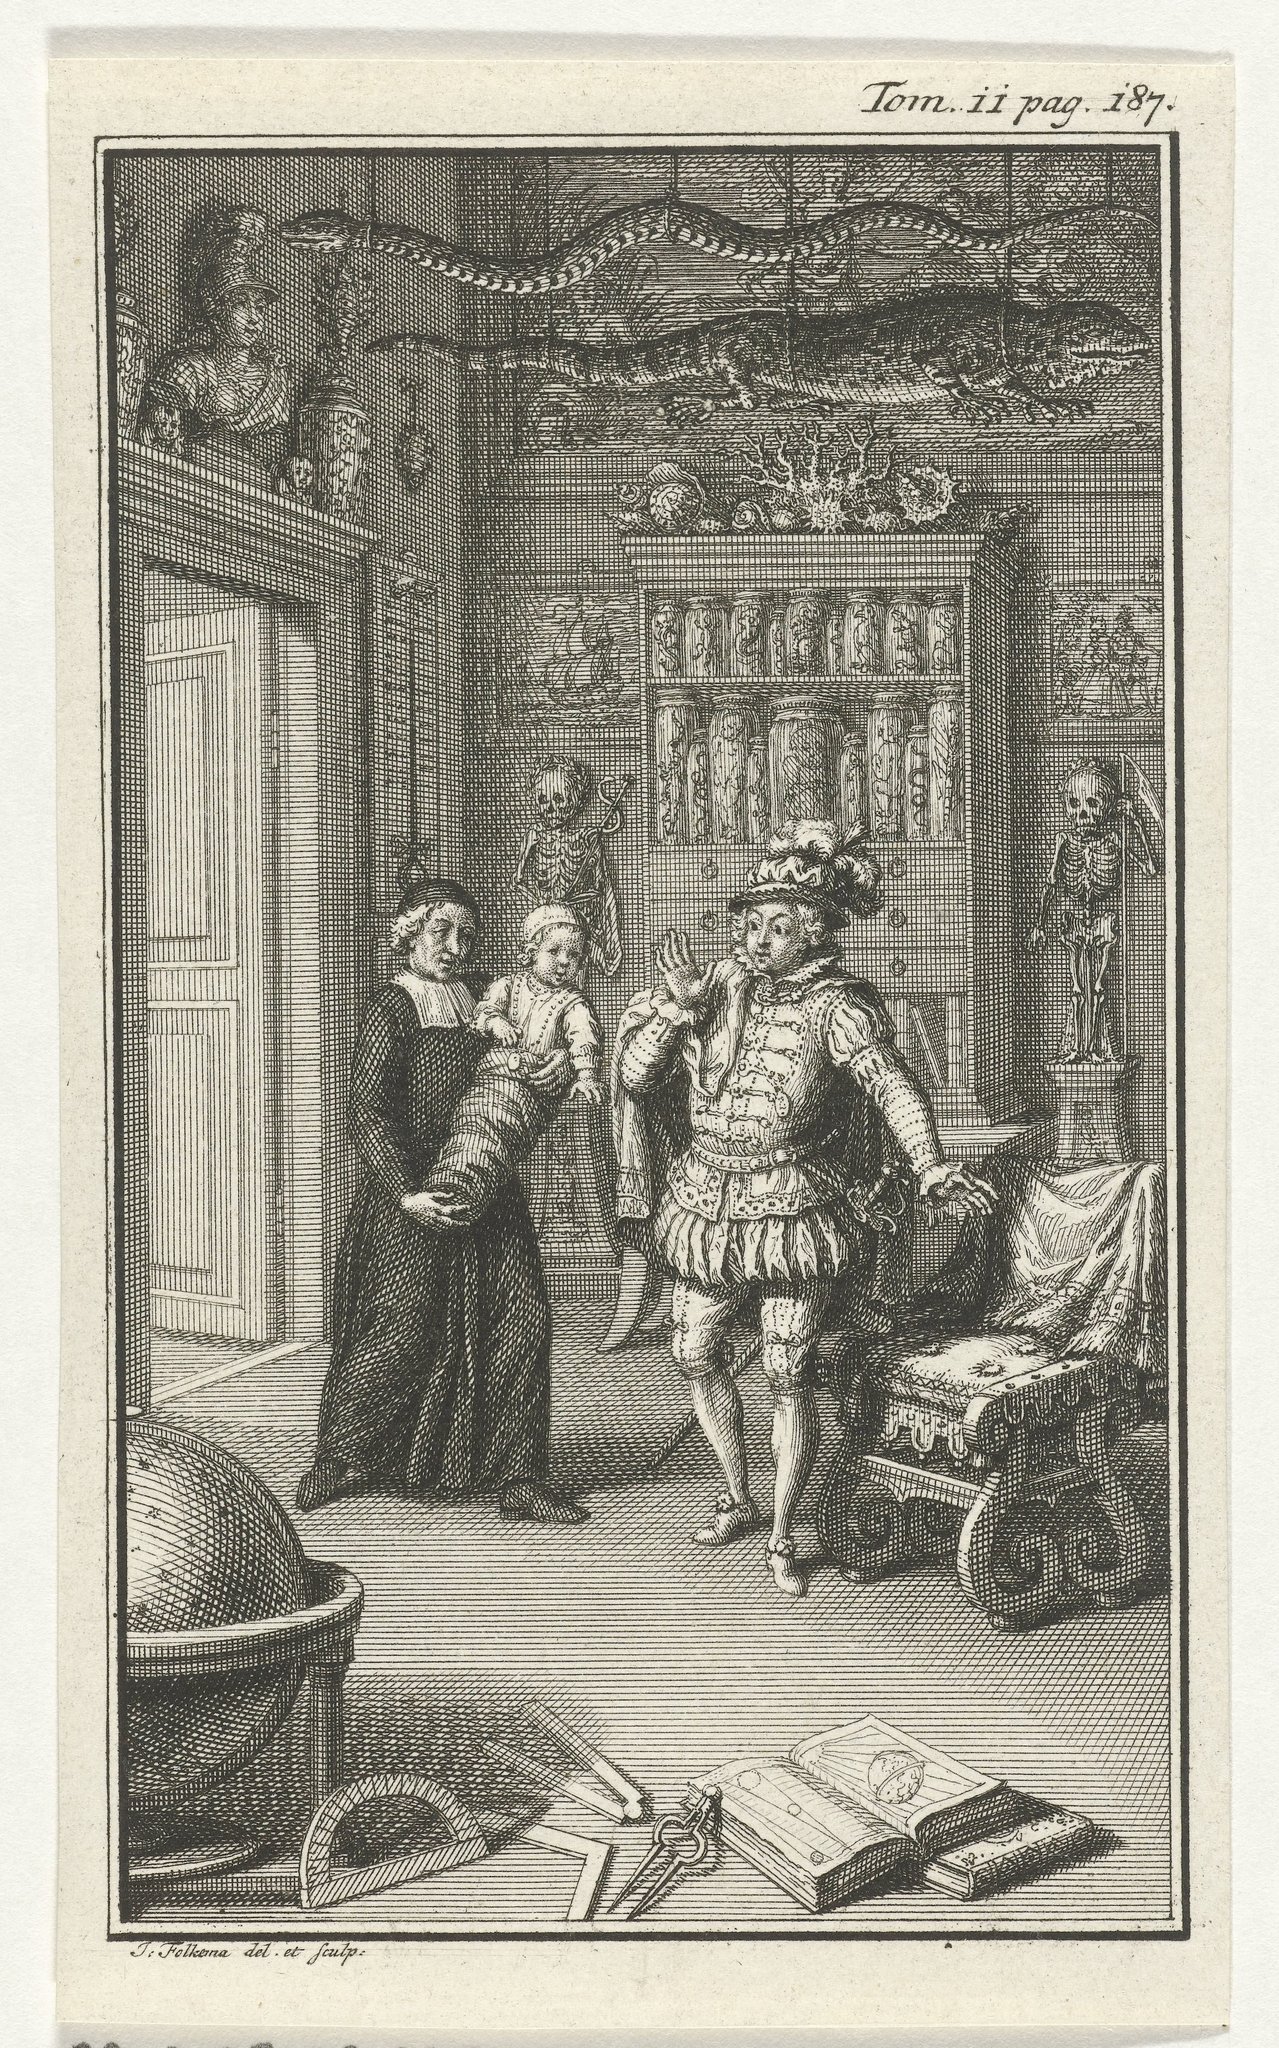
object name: book illustration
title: Edelman en een geestelijke met kind in een rariteitenkabinet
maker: jacob folkema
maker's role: draughtsman, print maker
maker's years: 1692-1767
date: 1702-1767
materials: paper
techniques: etching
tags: cabinet of curiosities, 'kunst- und wunderkammer'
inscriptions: collector's mark: Lugt 240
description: In een vertrek gevuld met talrijke rariteiten bevinden zich een edelman en een geestelijke met een kind in zijn armen. Prent rechtsboven gemerkt: Tom. ii pag. 187.